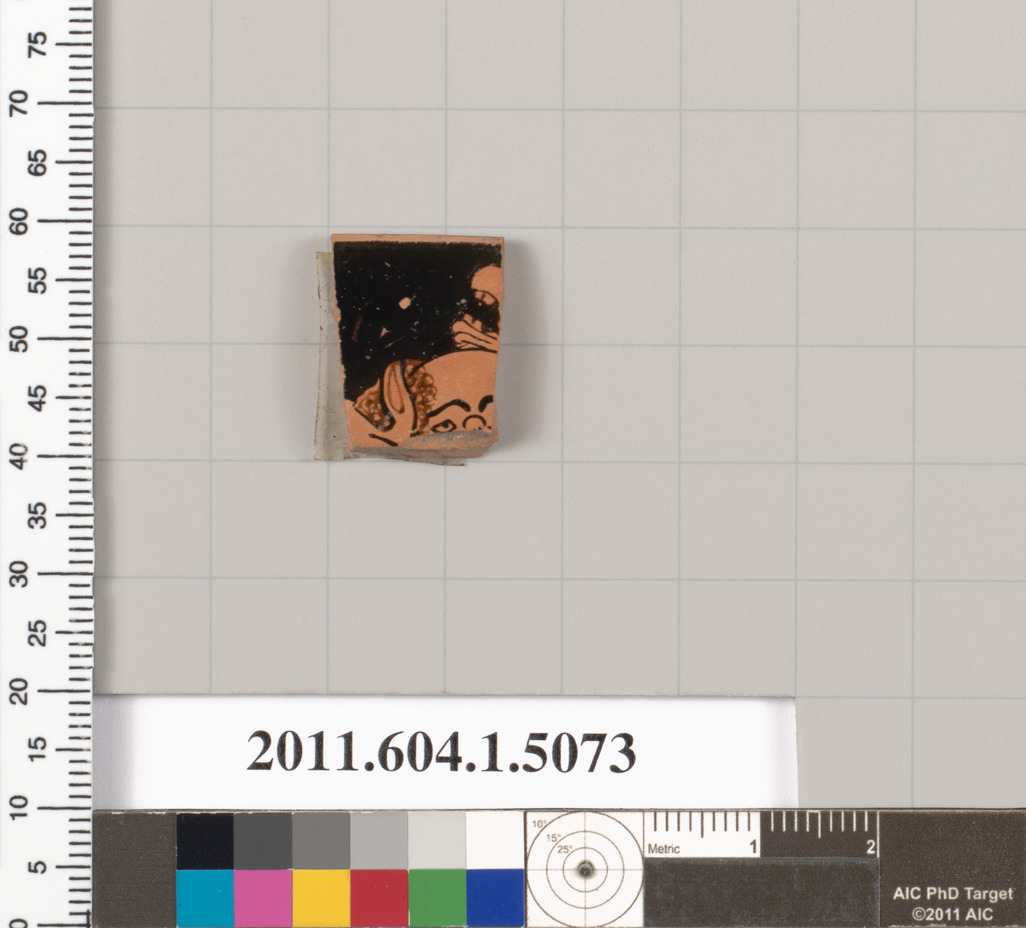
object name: kylix fragment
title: Terracotta rim fragment of a kylix (drinking cup)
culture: greek, attic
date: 500-480 BCE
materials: terracotta